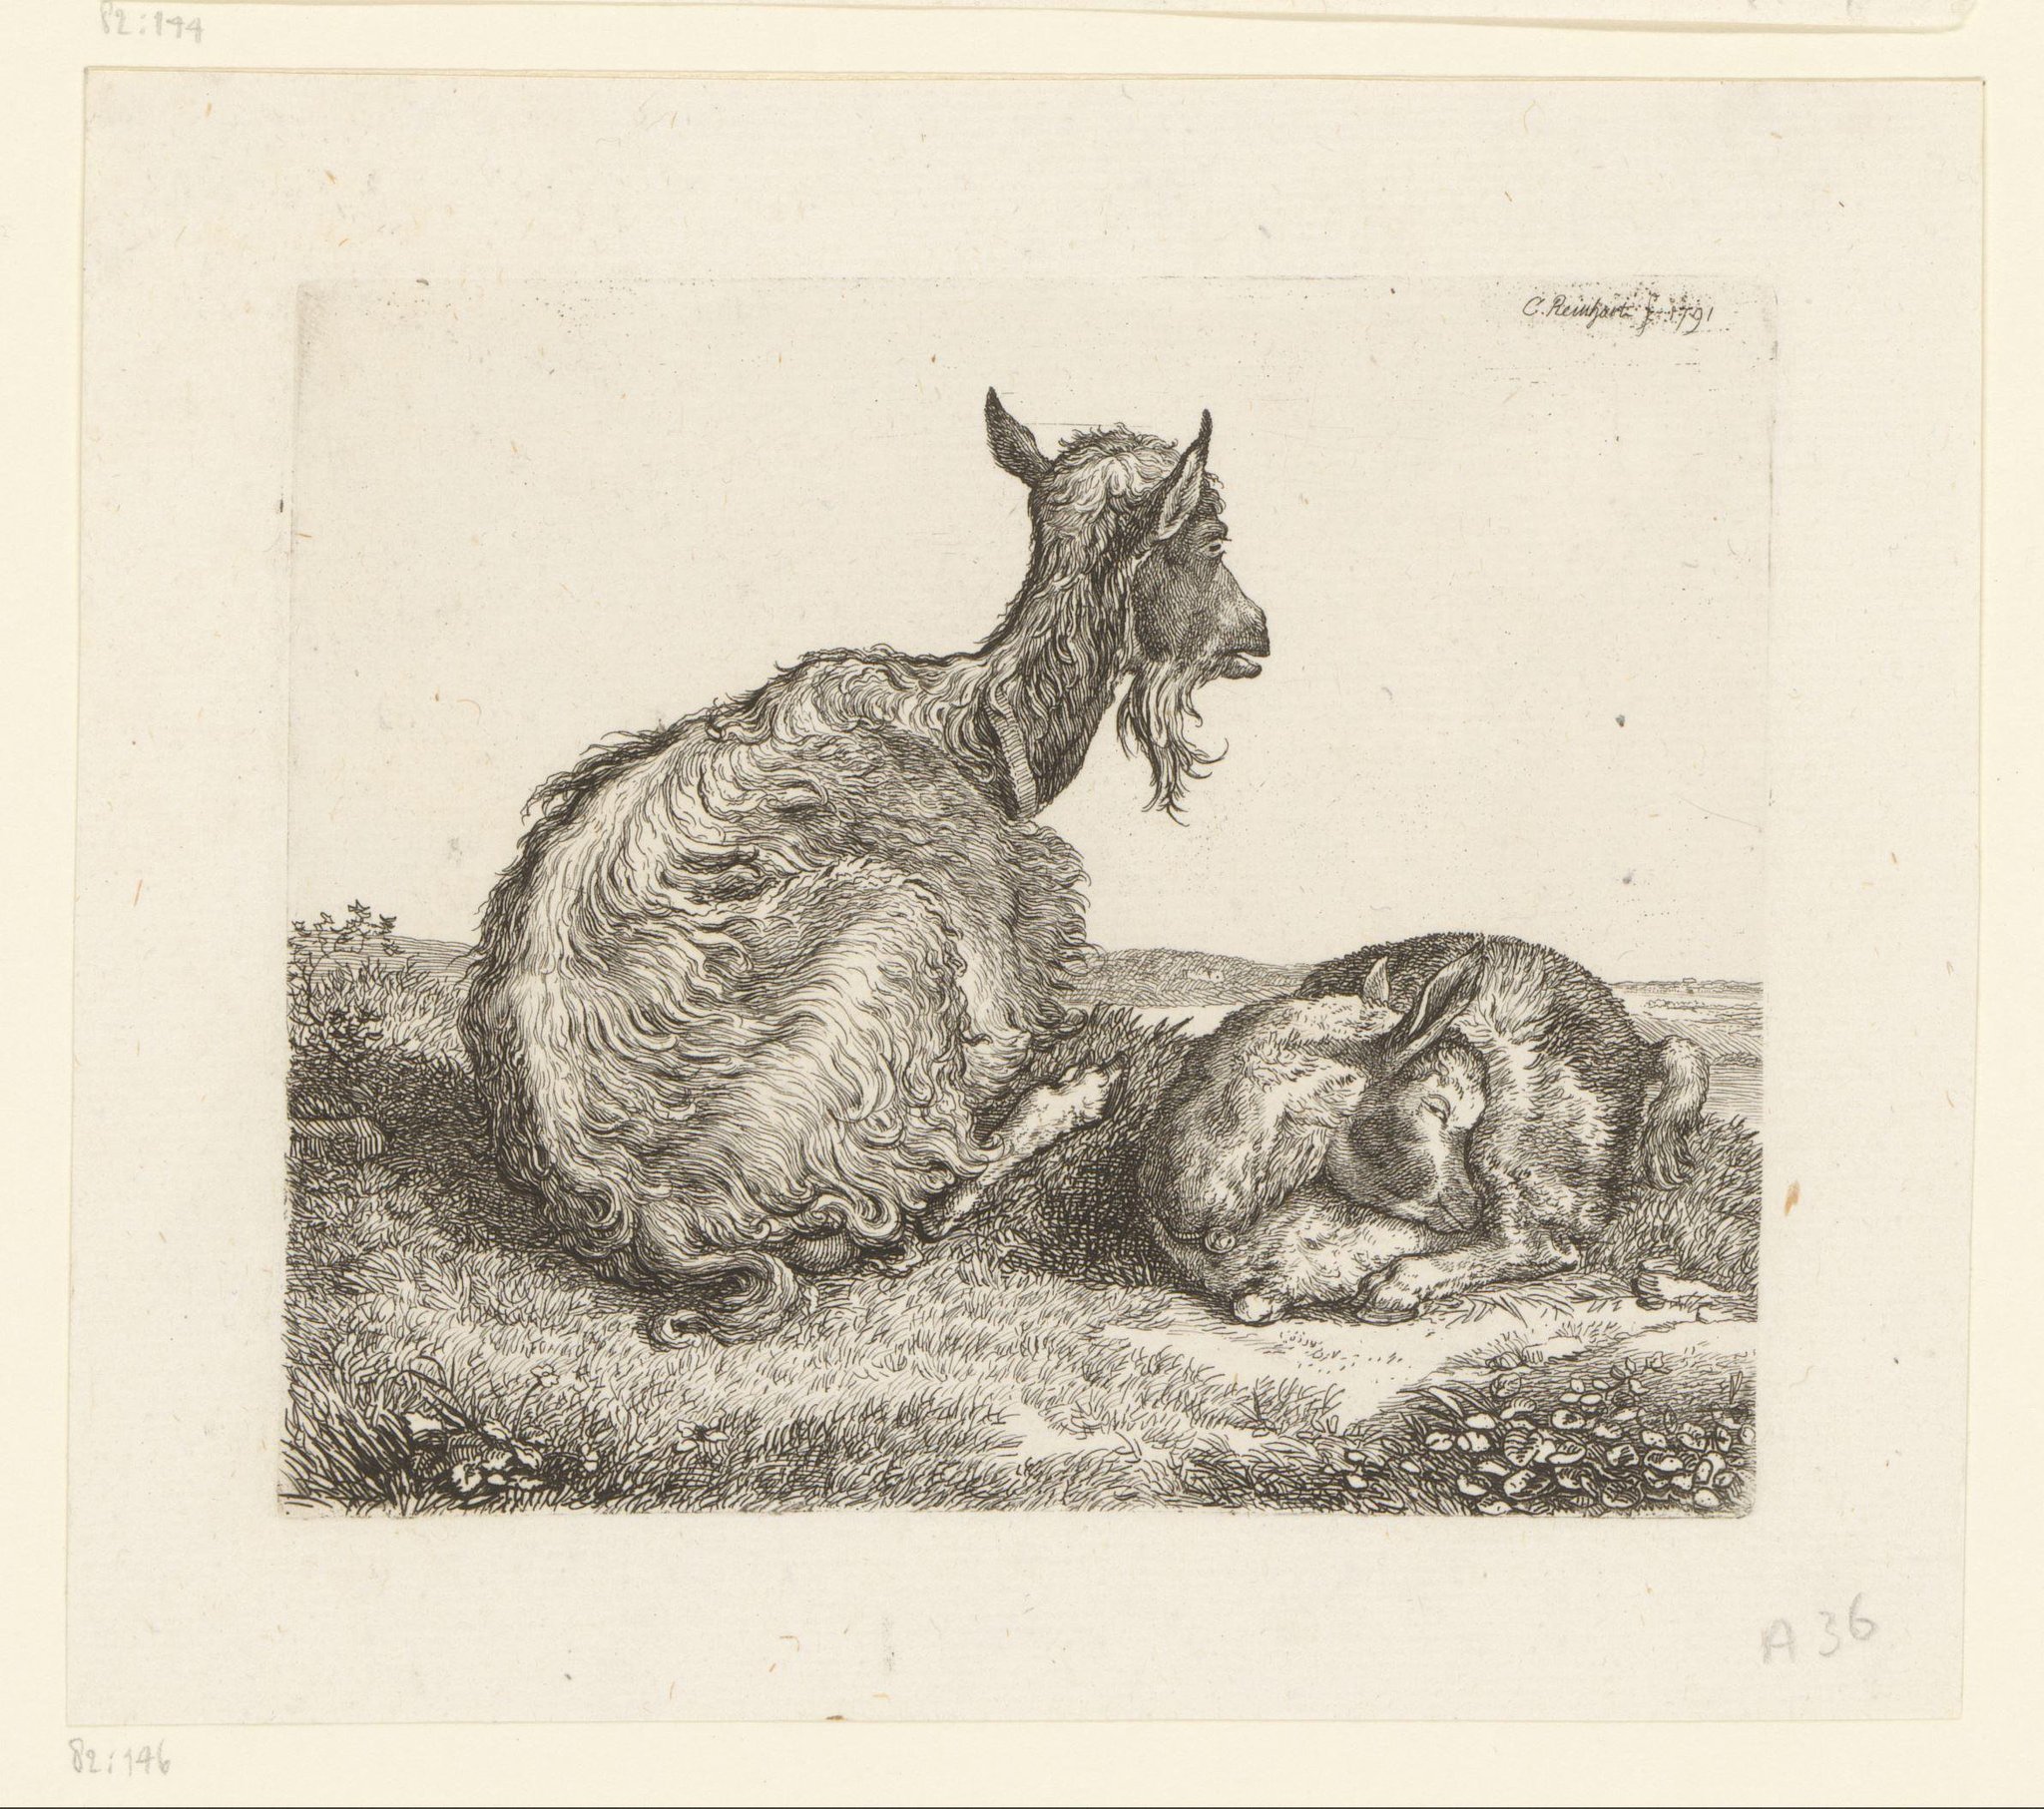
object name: print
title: Die erste Thierfolge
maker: johann christian reinhart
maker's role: print maker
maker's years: 1761-1847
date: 1791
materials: paper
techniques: etching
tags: landscapes, goat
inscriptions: collector's mark: Lugt 2228, collector's mark: Lugt 2760